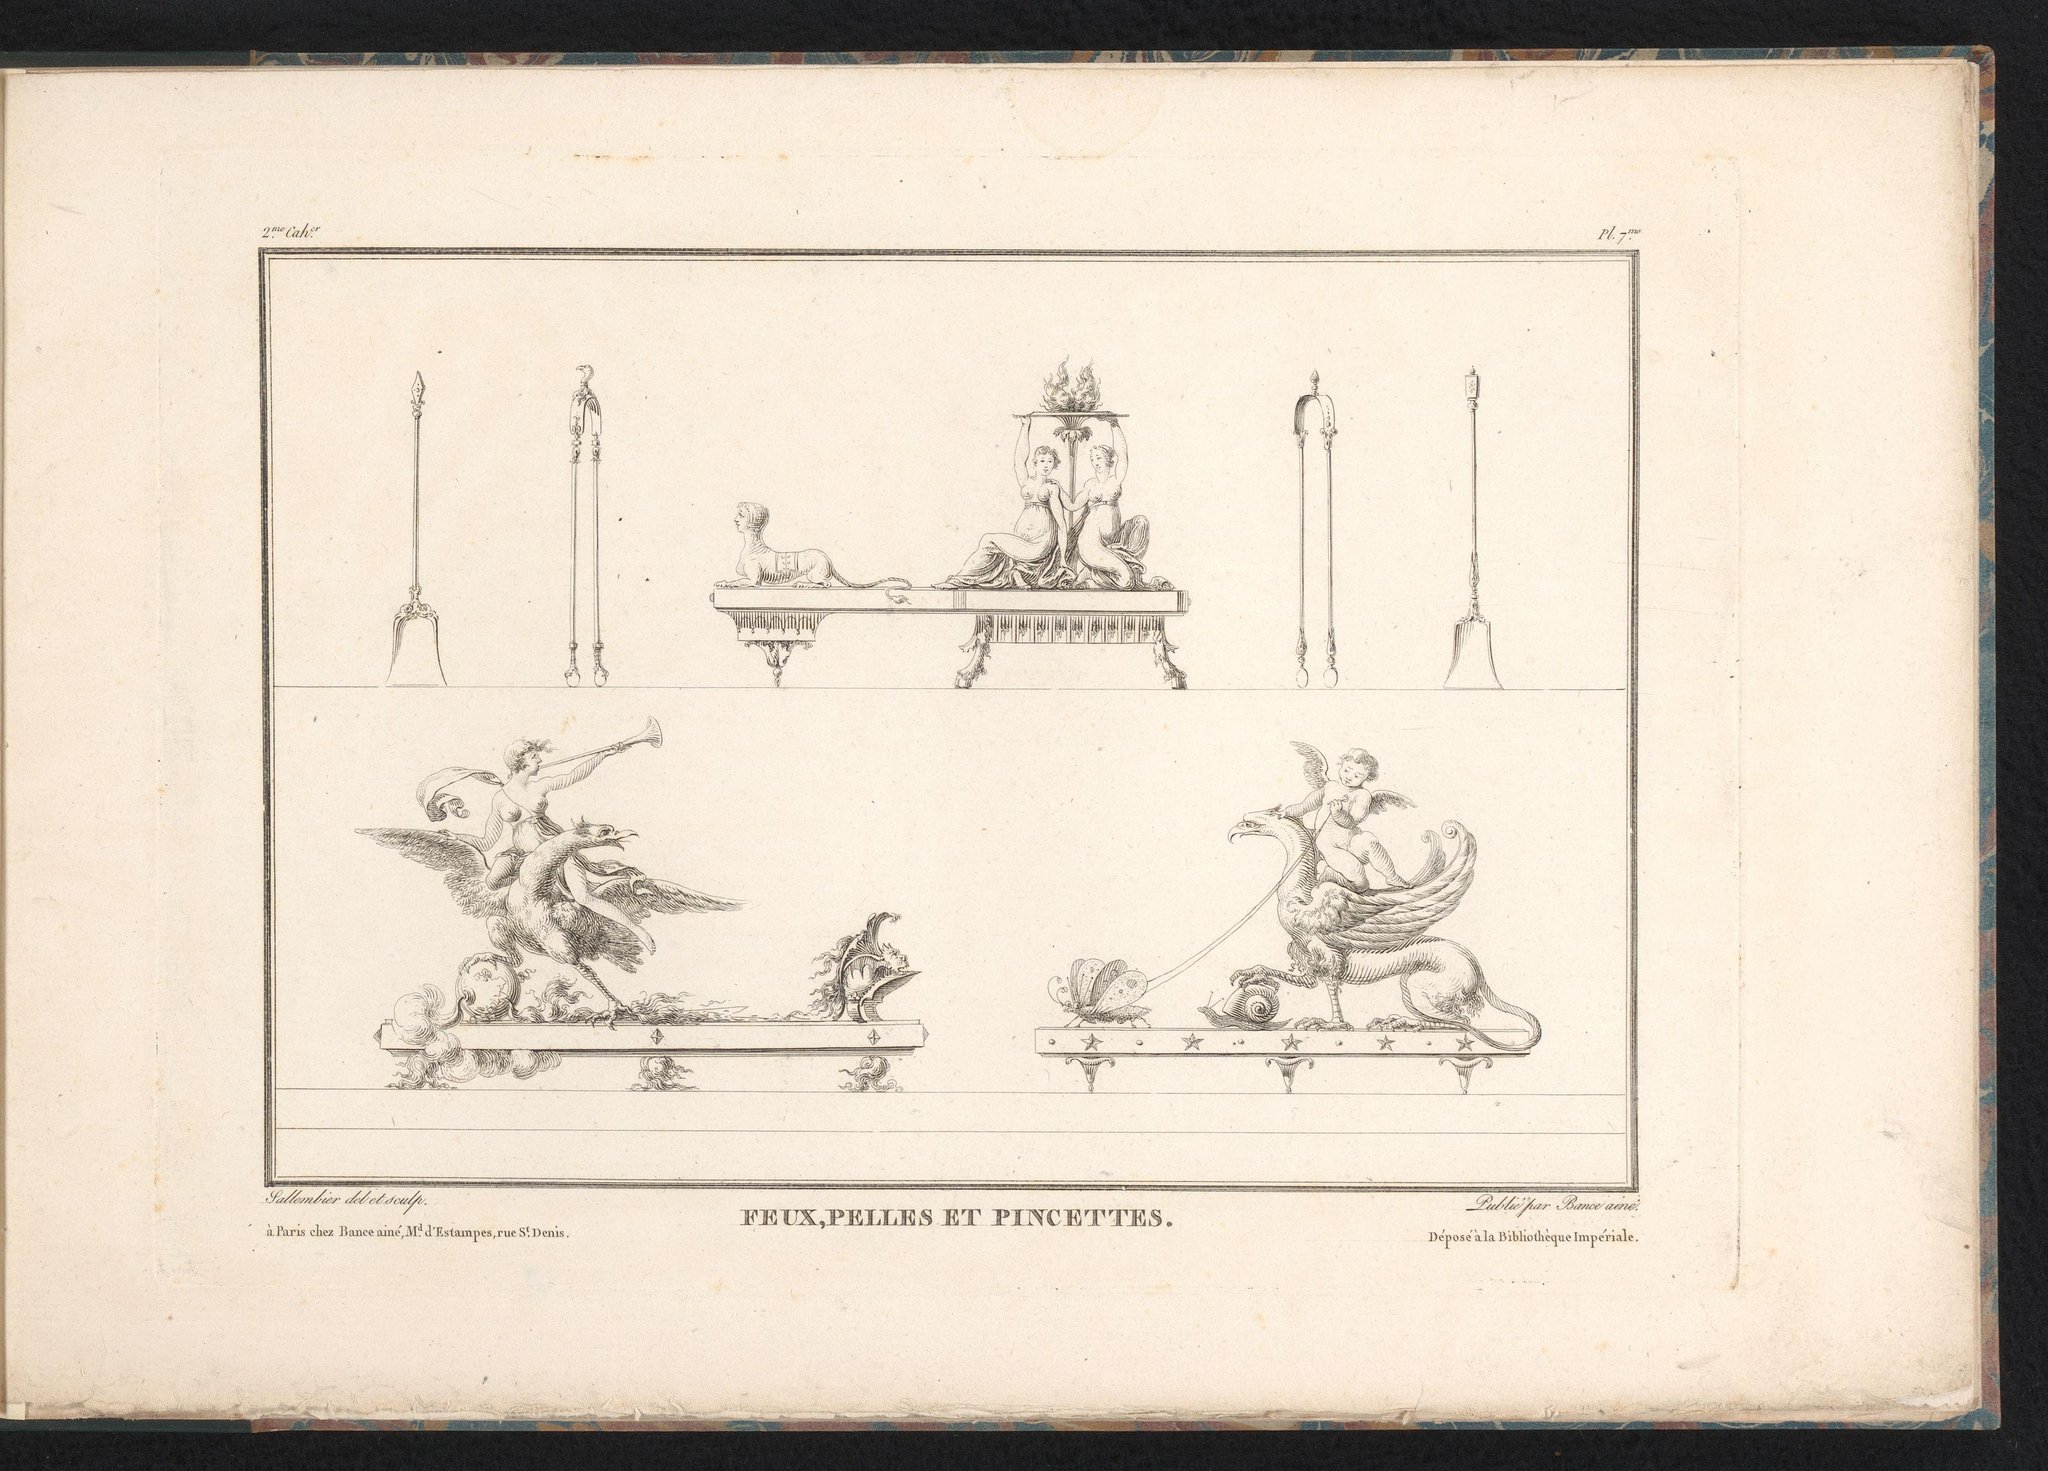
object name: ornament print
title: Modèles d'Orfèvrerie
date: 1805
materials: paper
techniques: etching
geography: paris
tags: griffin (lion/eagle); 'griffo' (ripa), sphinx (lion/woman); 'sfinge' (ripa), andiron, fire-dog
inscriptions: number: ‘2.me Cah.er’, : ‘Déposé à la Bibliothèque Impériale’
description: Ontwerpen voor instrumenten om te gebruiken bij de haard zoals een asschep. Ook zijn er drie gedetailleerde vuurbokken, met als decoratie onder meer een sfinx en een griffioen. Prent maakt deel uit van een album.